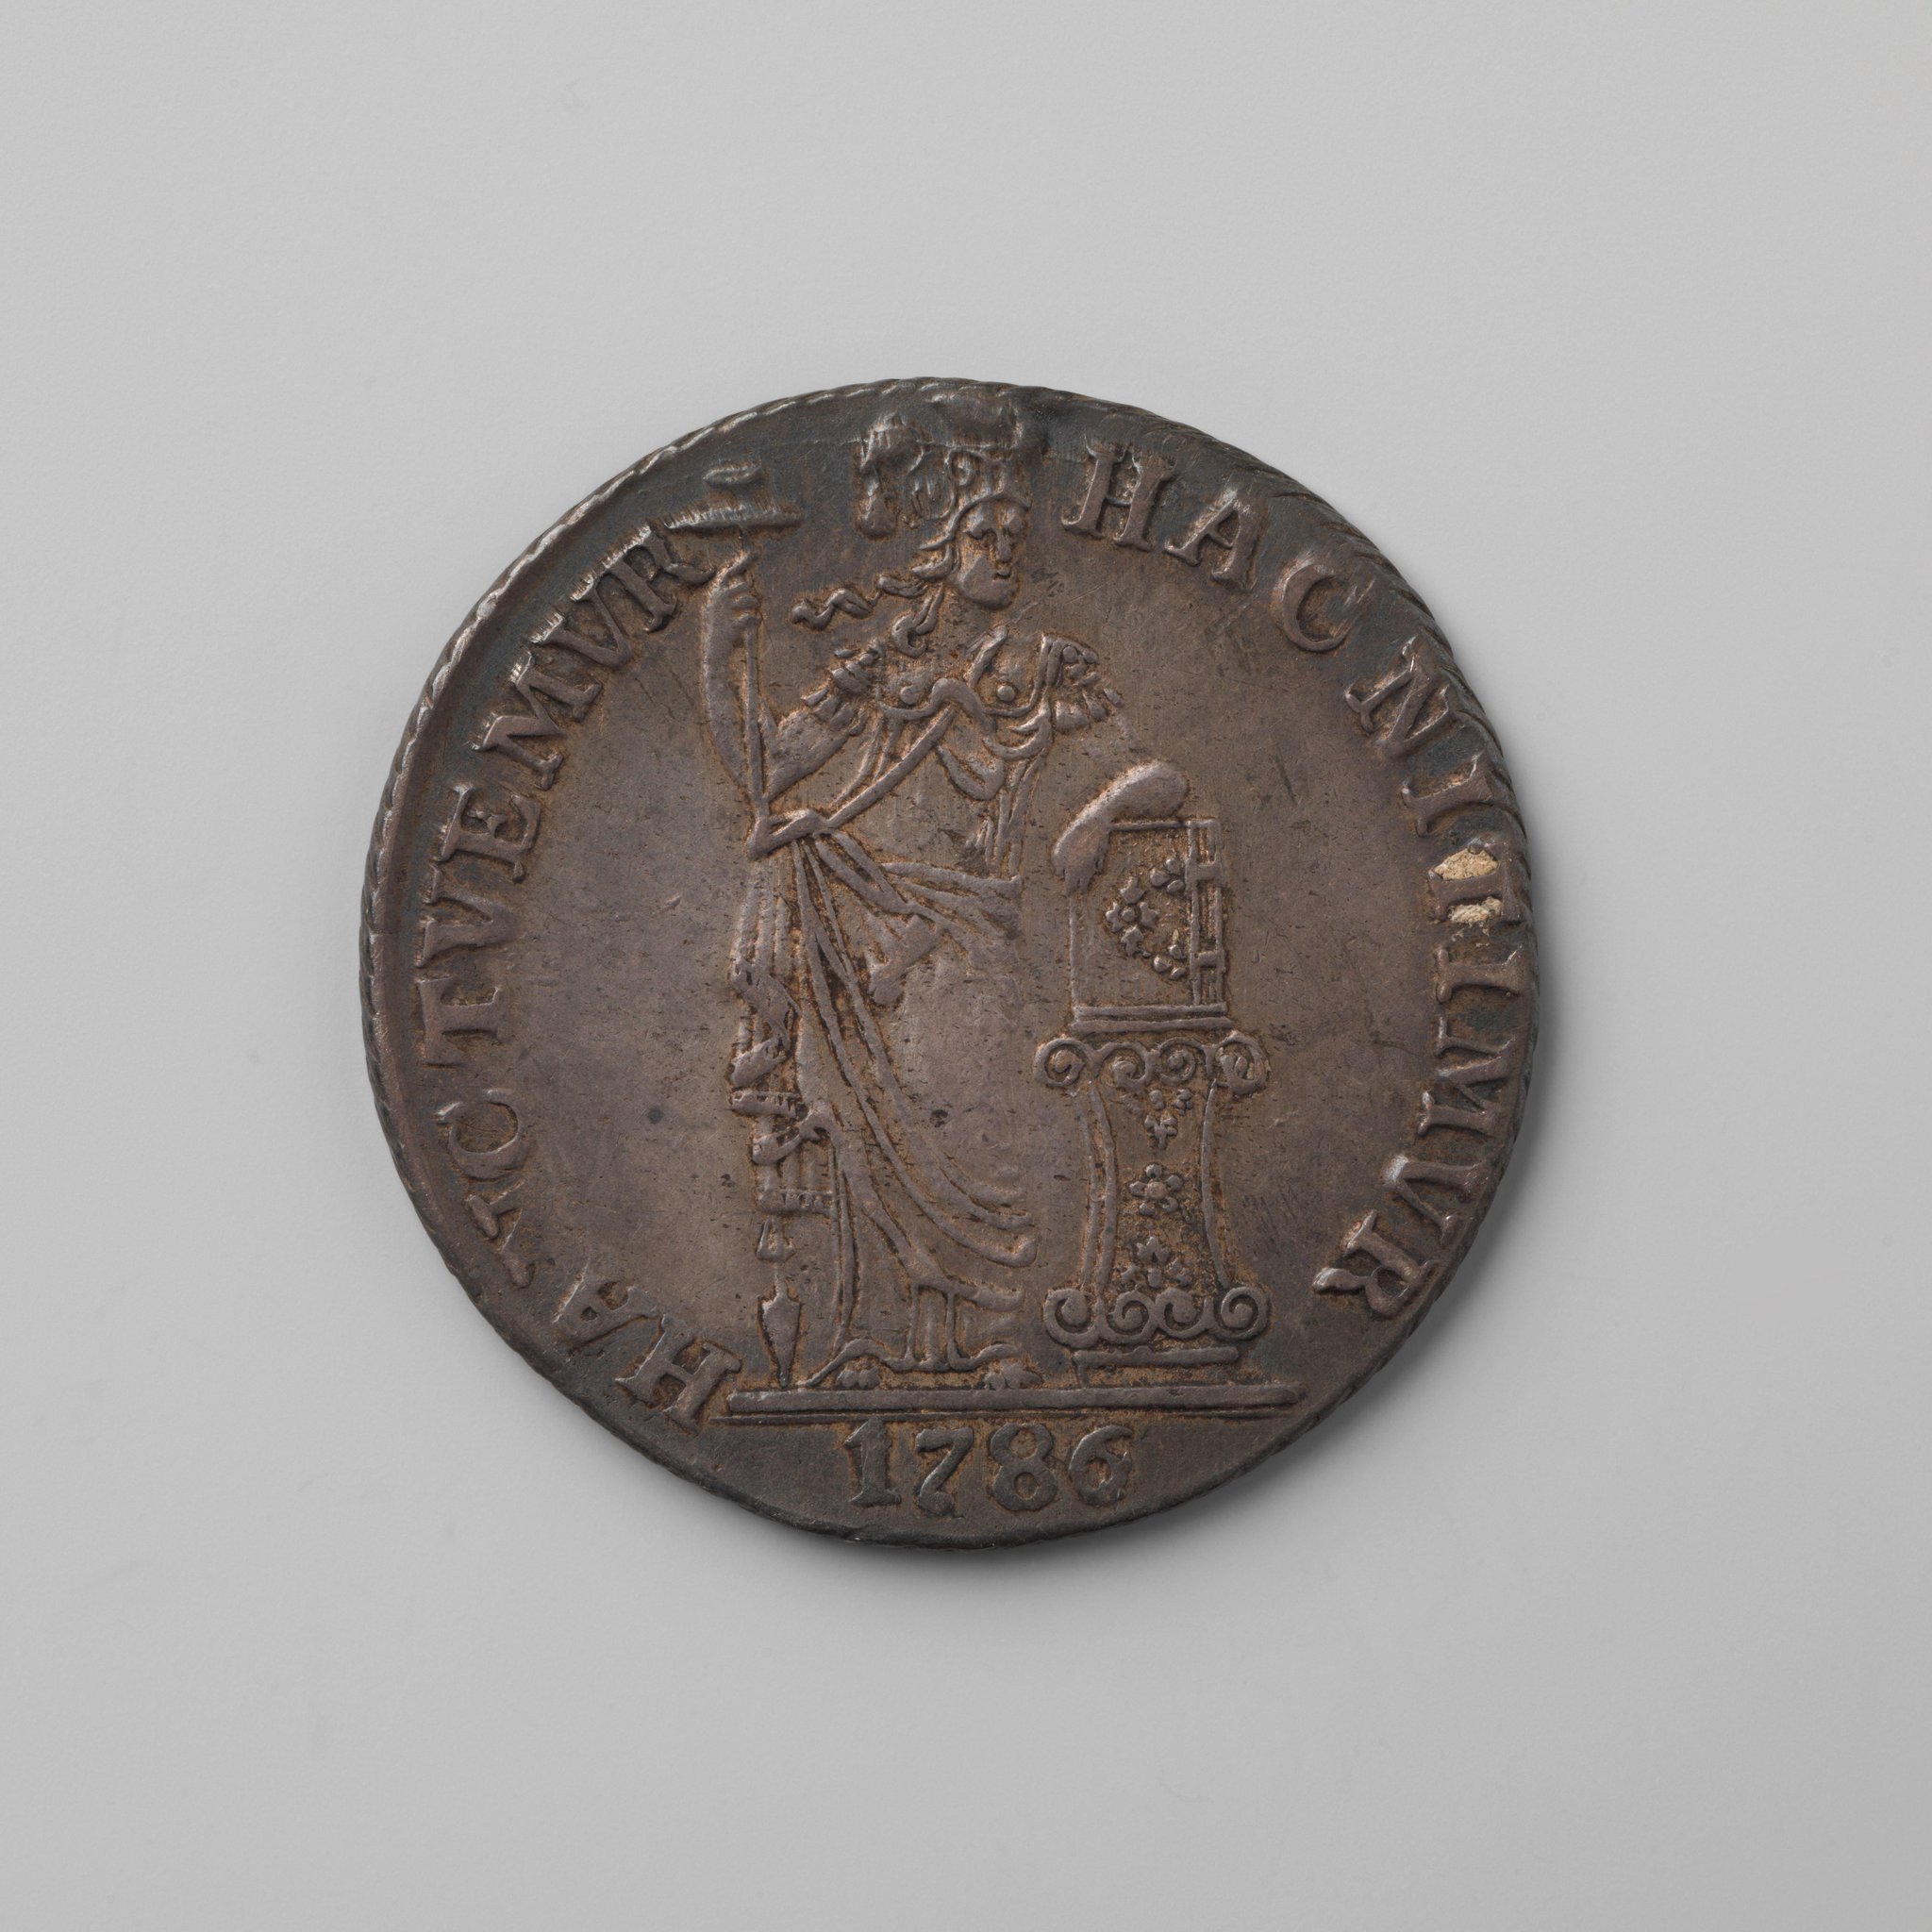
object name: coin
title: VOC, gulden, Westfriesland,1786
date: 1786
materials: silver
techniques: striking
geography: hoorn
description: Zilveren munt. Voorzijde: tussen waarde-aanduiding I Gl. gekroond generaliteitswapenschild, waaronder cartouche, waarin monogram van de VOC. Keerzijde: Nederlandse maagd met speer, waarop vrijheidshoed, leunend op een bijbel op een altaar. Jaartal in afsnede. Kabelrand.